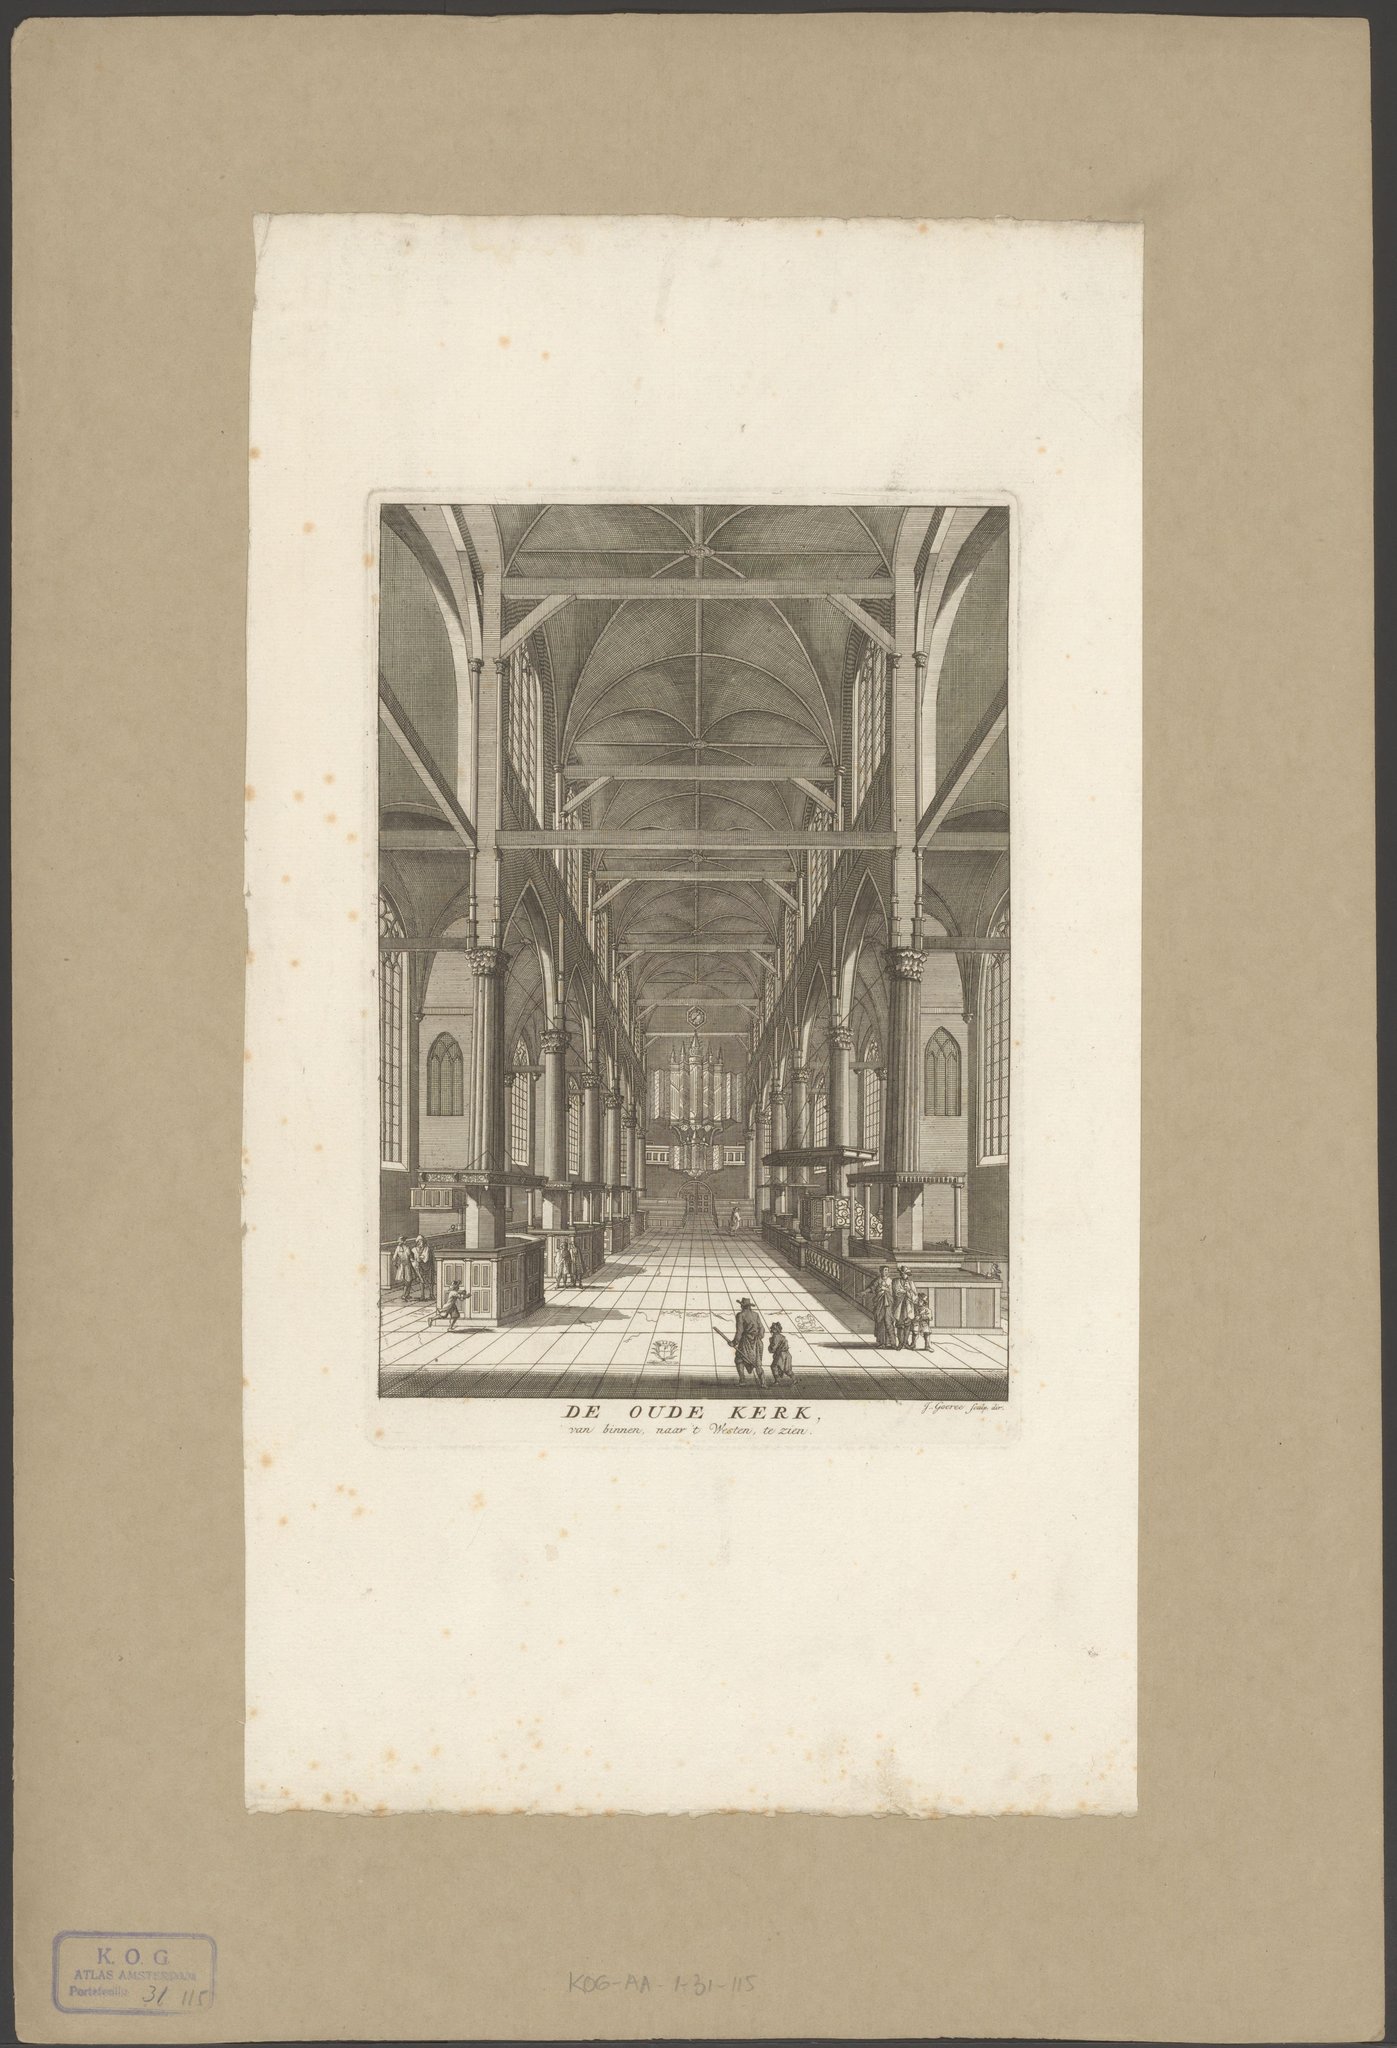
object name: book illustration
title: Interieur van de Oude Kerk van Amsterdam, gezien naar het westen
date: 1715-1731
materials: paper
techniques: engraving, etching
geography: amsterdam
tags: parts of church interior: aisle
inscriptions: collector's mark: ‘31.115’ Lugt 1641b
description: Prent uit: Wagenaar, Jan. Amsterdam, in zyne opkomst, aanwas, geschiedenissen (...), 2de dl. Amsterdam: Isaak Tirion, 1765, tussen 100-101.